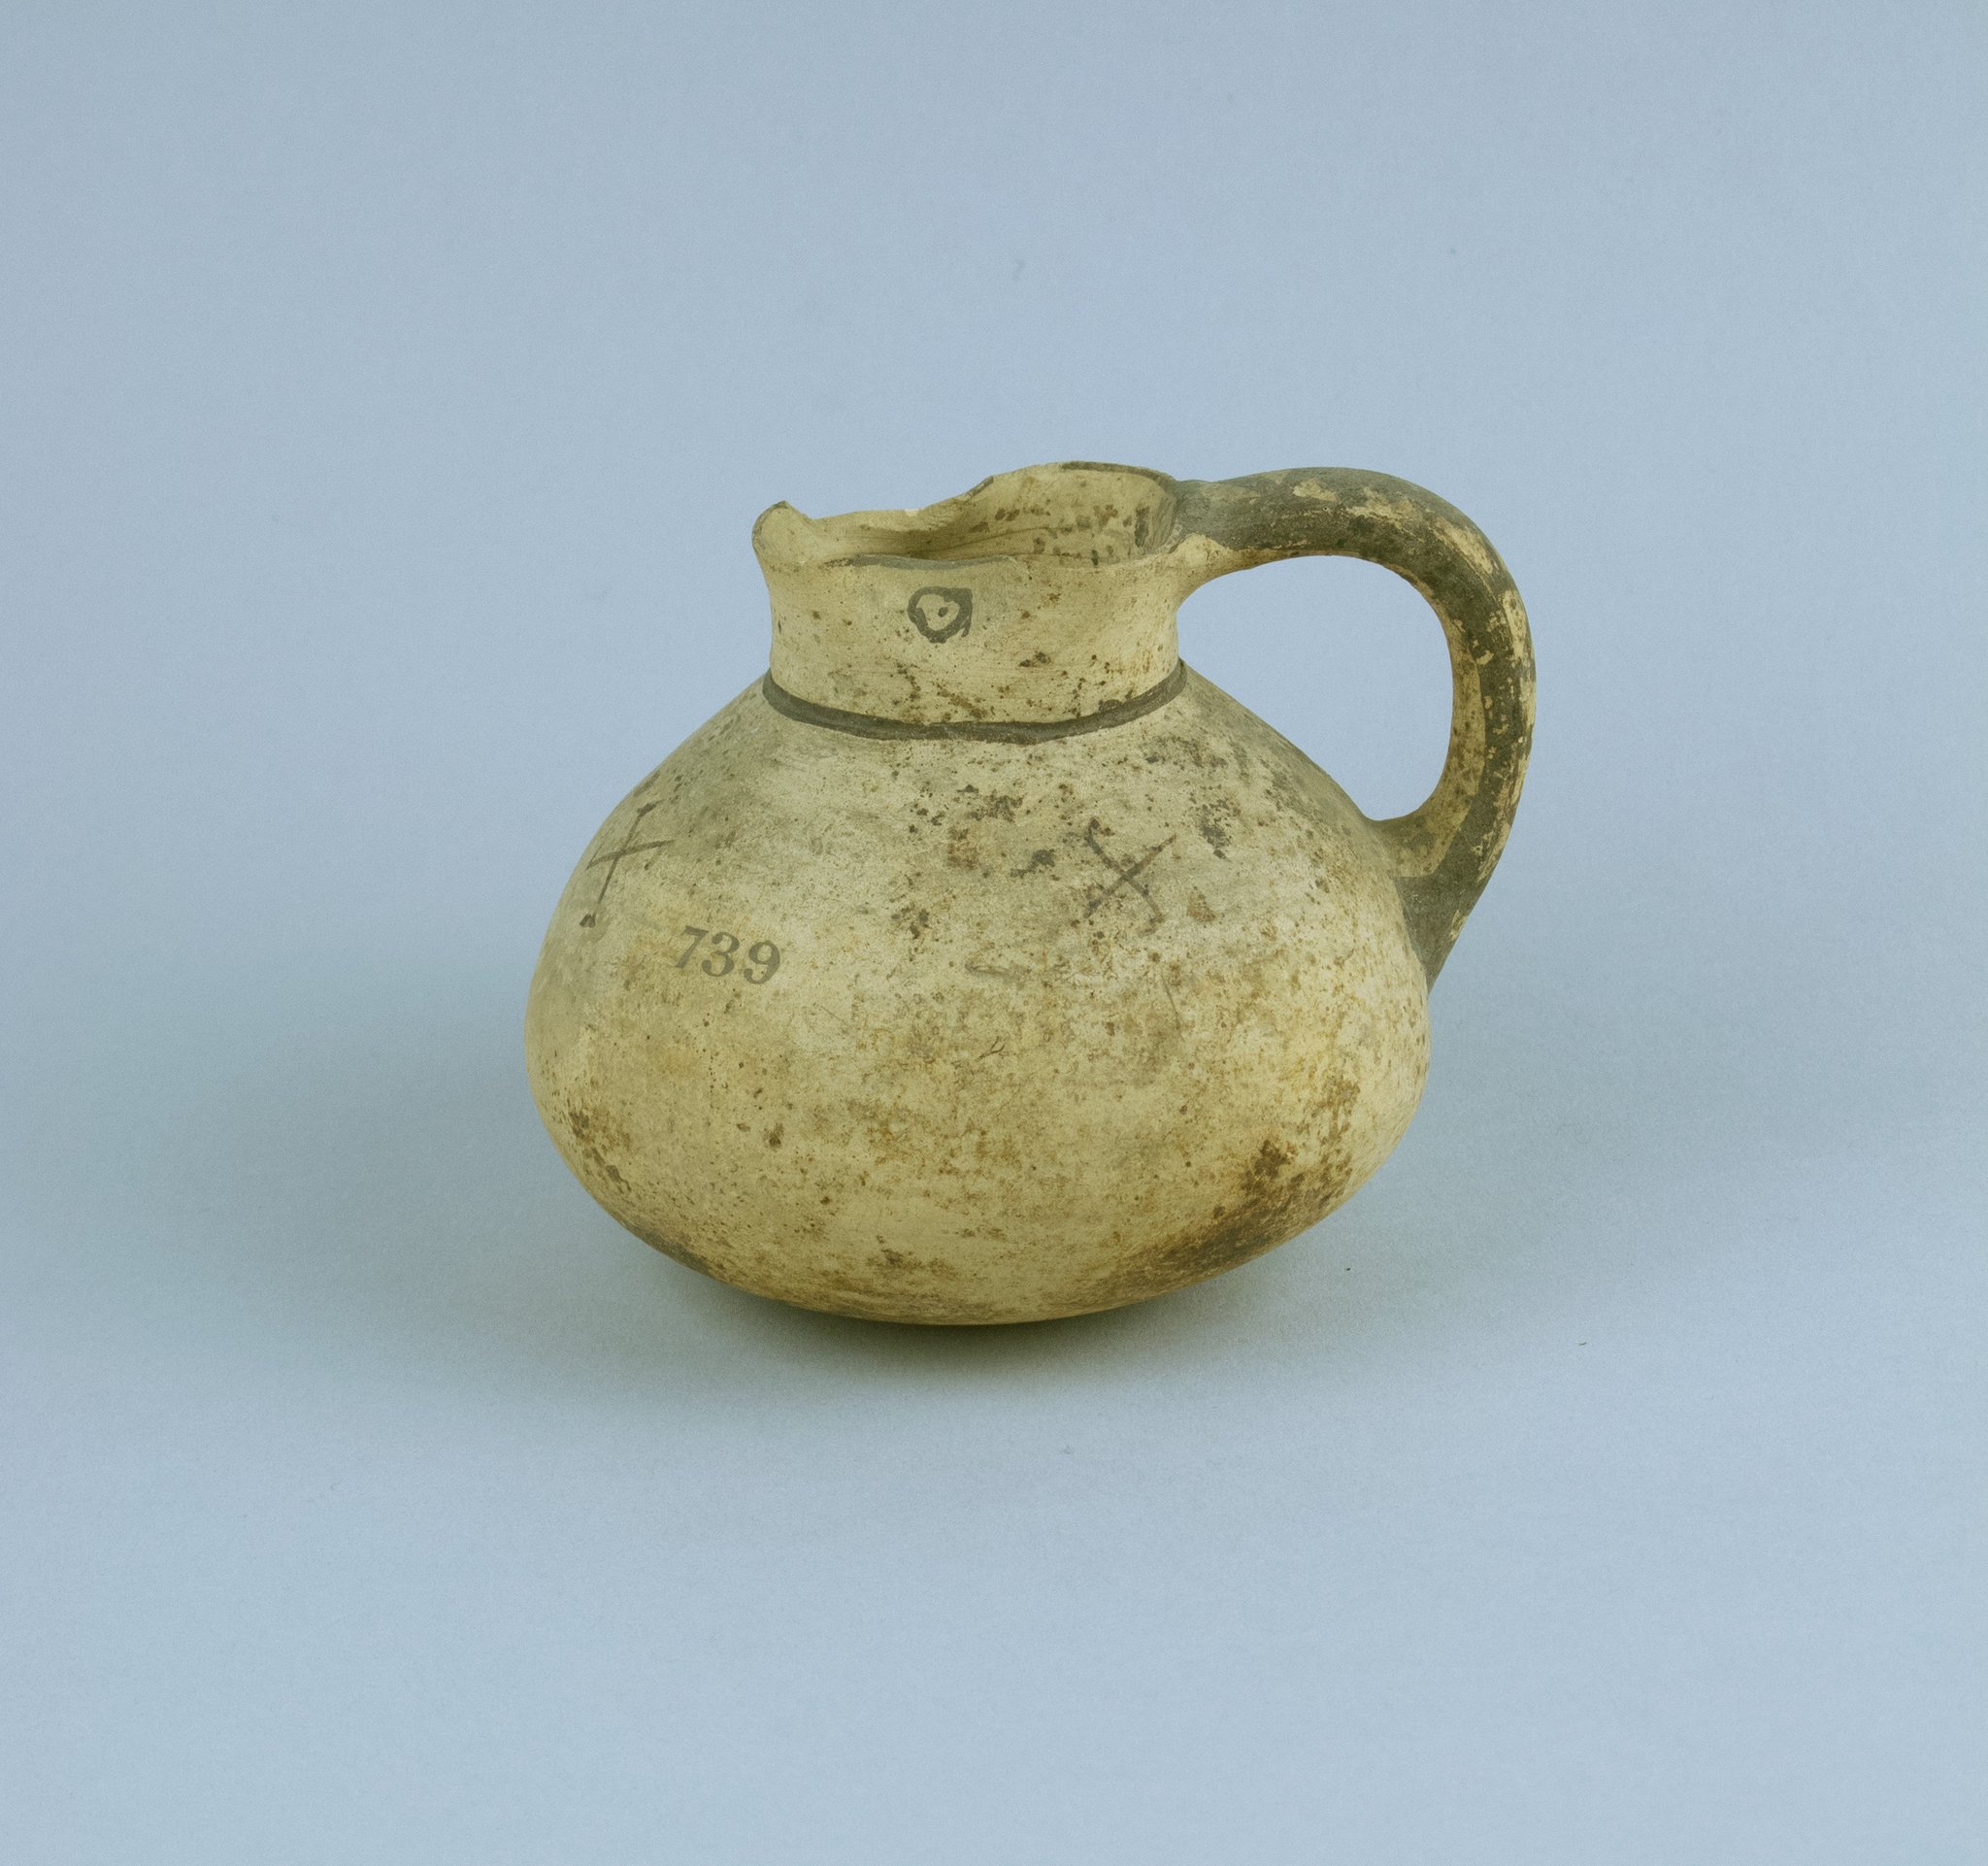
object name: oinochoe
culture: cypriot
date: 1125-1050 BCE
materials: terracotta